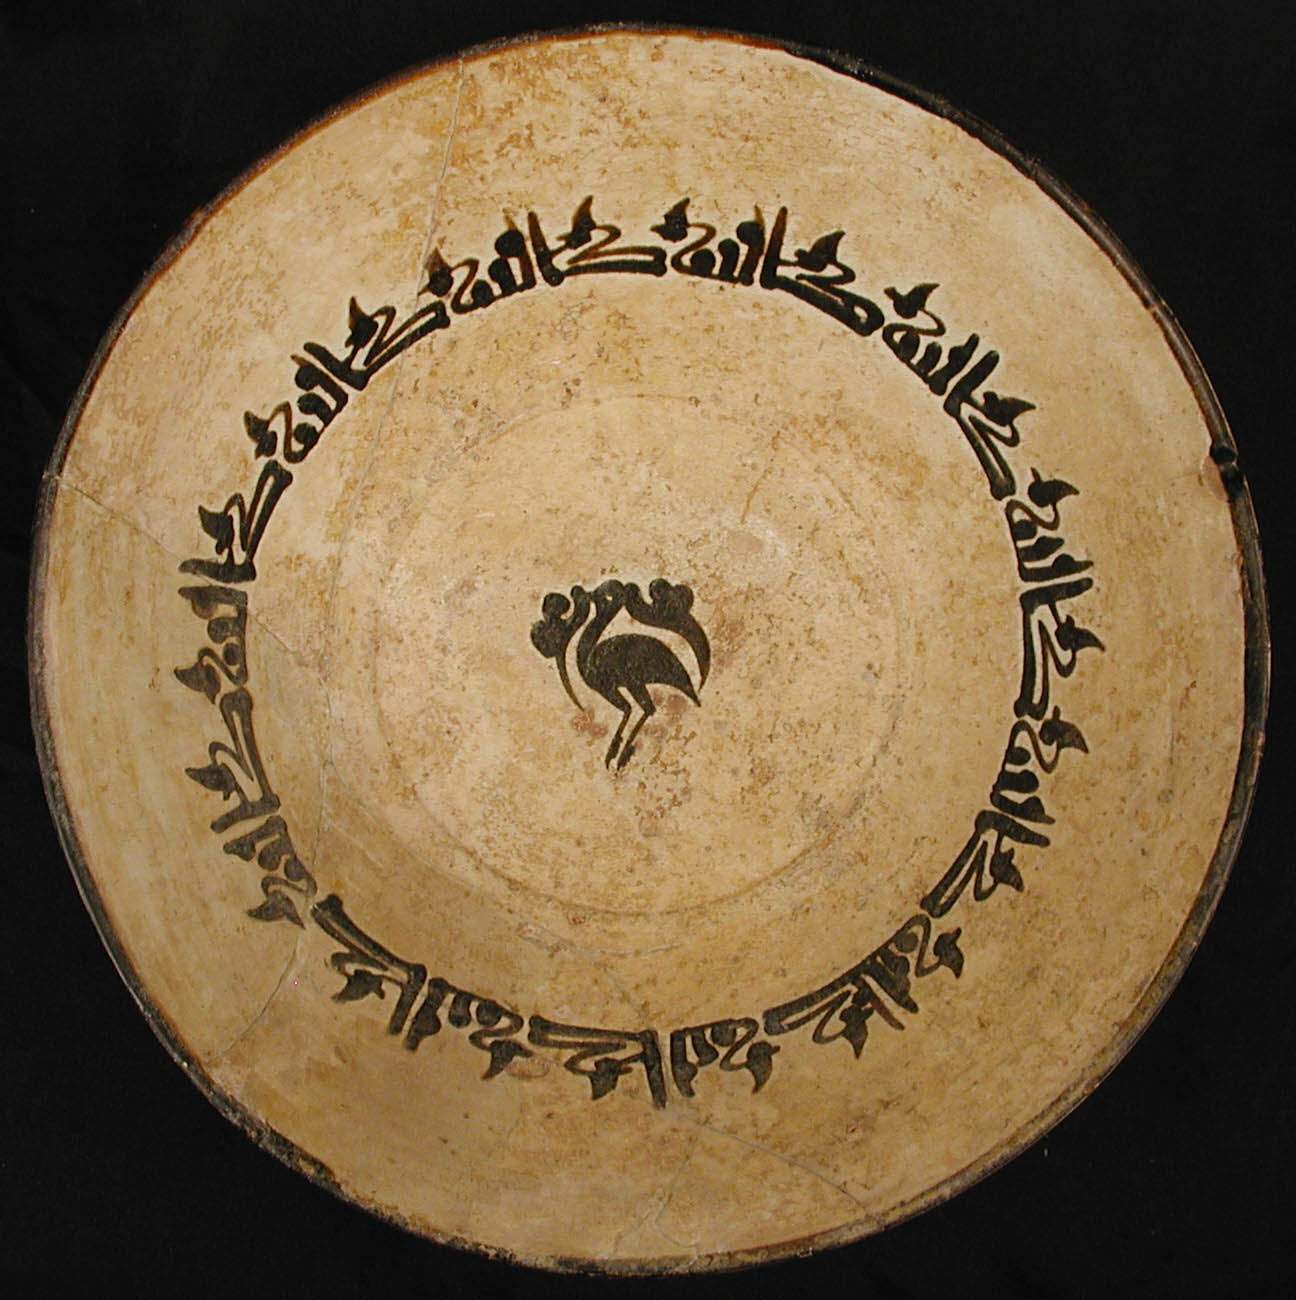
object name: bowl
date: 867-933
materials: earthenware, glaze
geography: iran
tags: birds